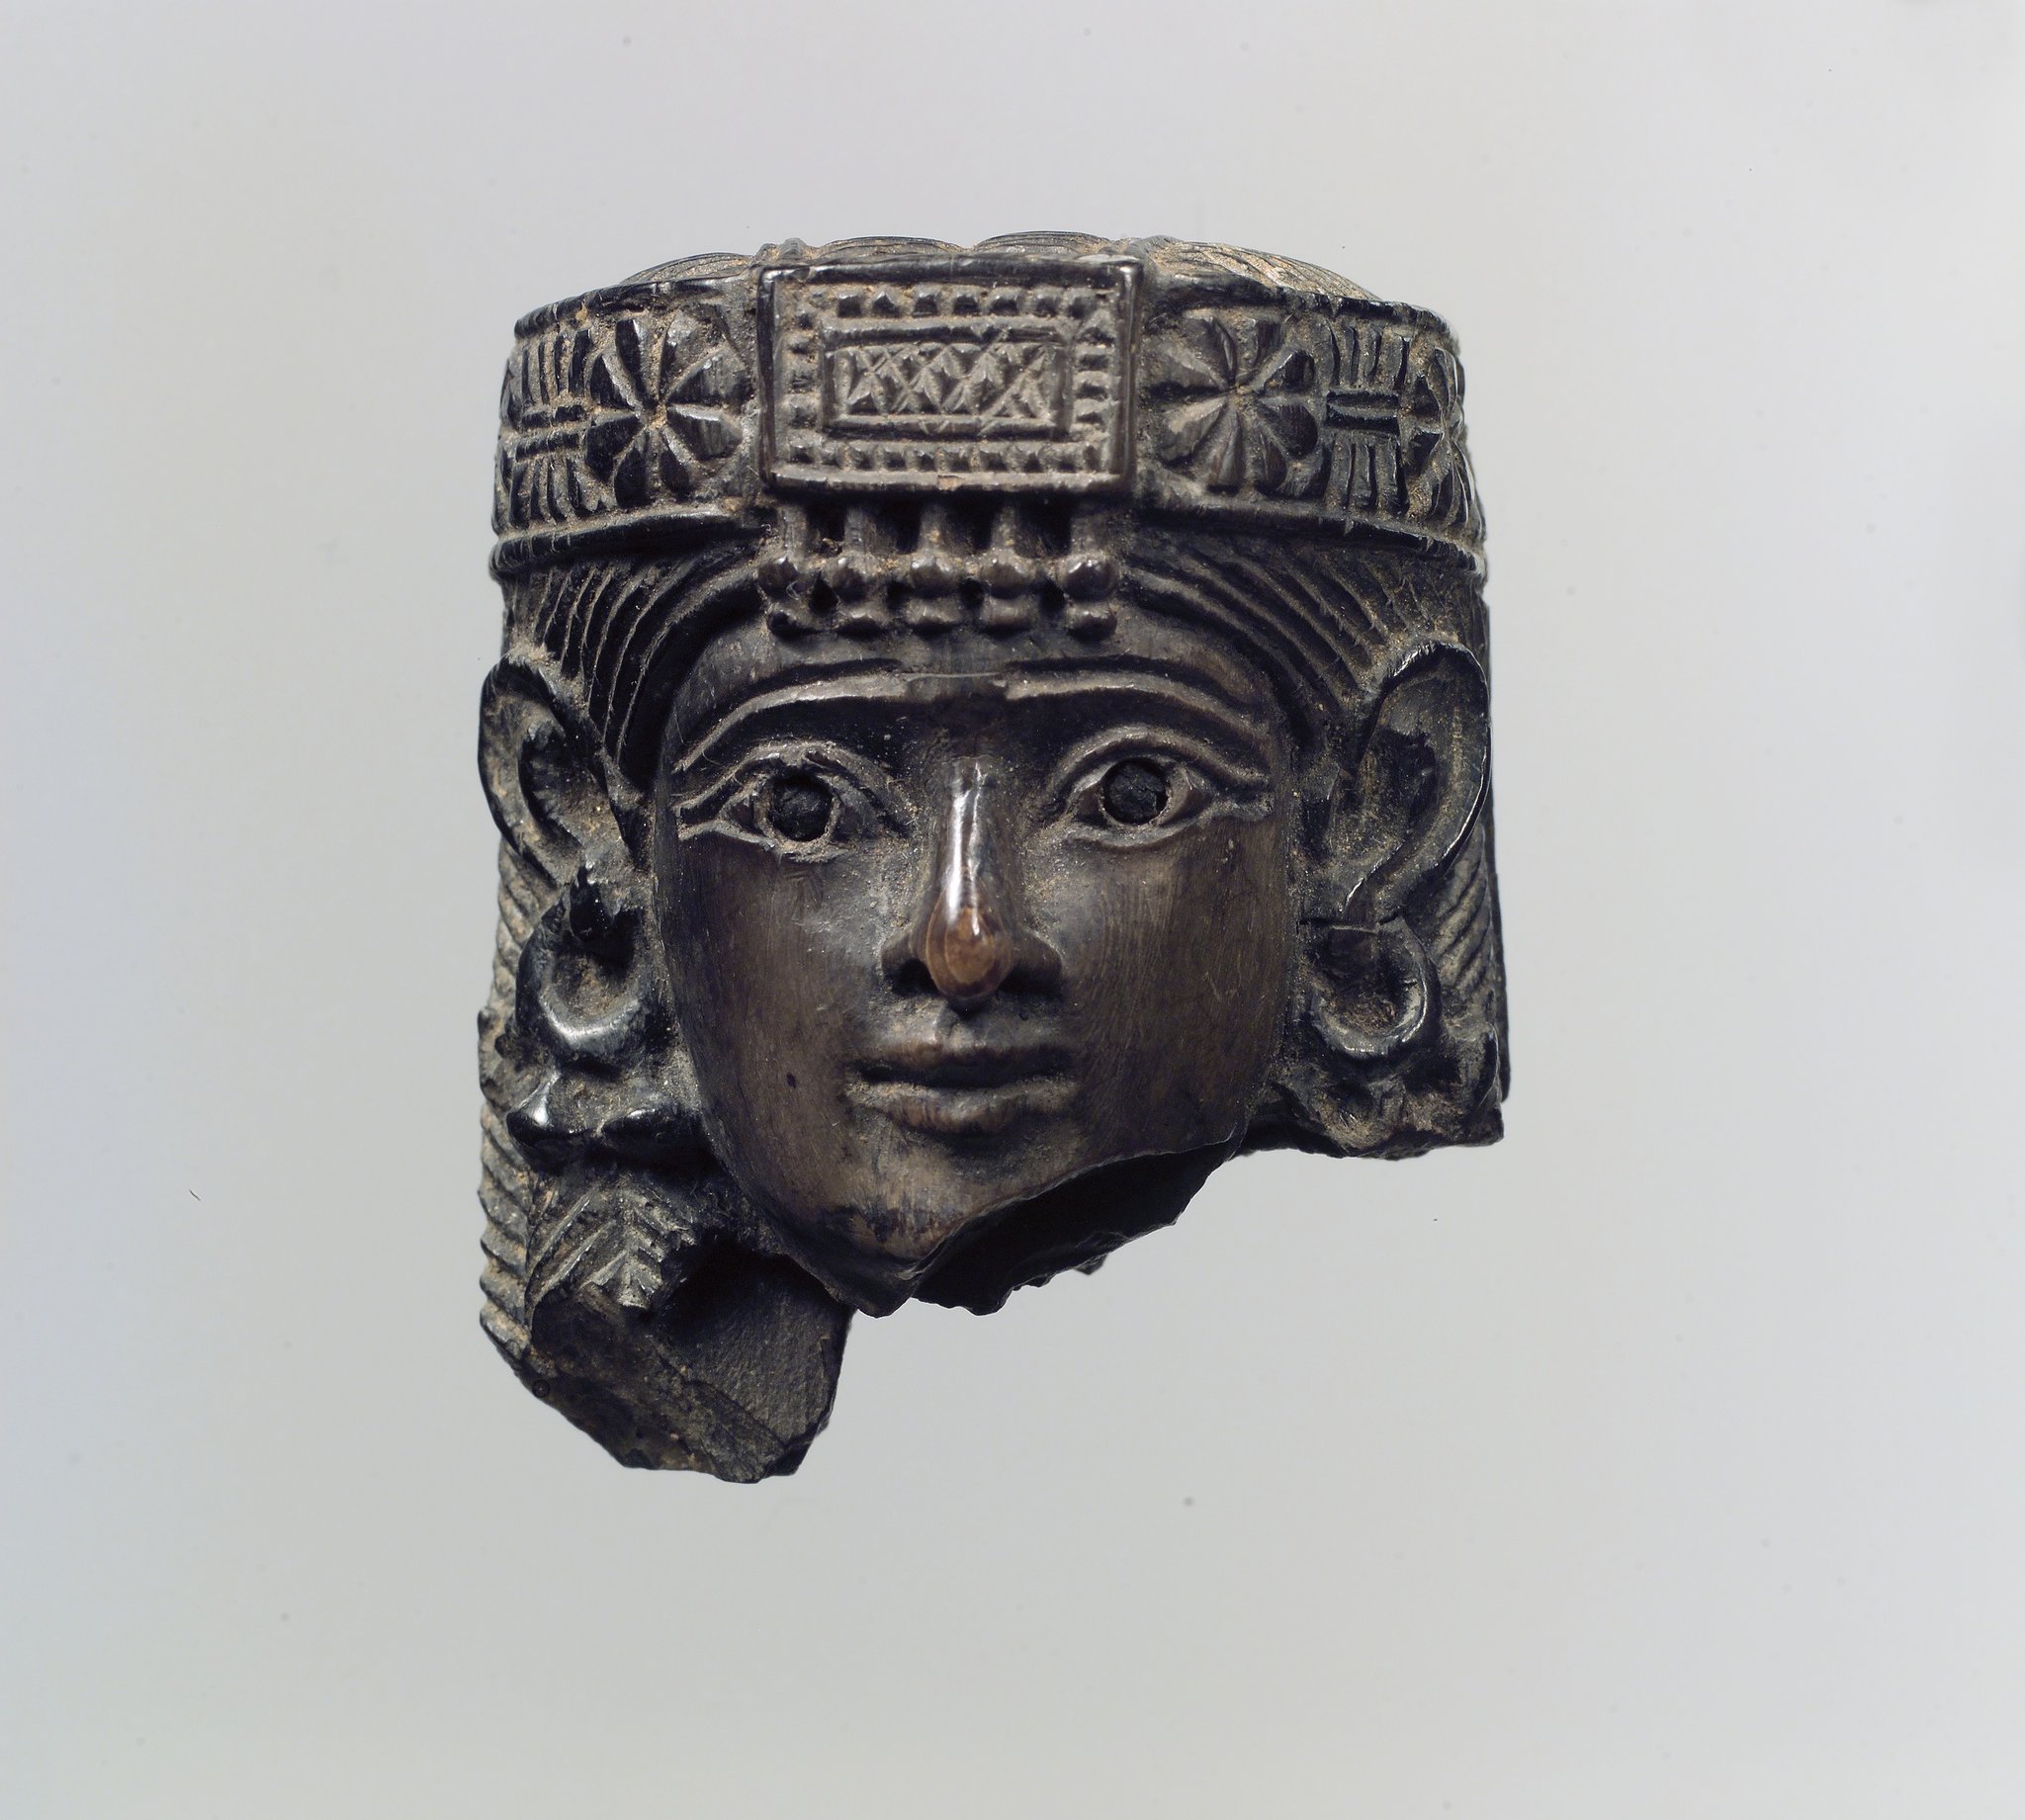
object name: sculpture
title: Head of a female figure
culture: assyrian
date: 800-701 BCE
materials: ivory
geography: mesopotamia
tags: heads,women